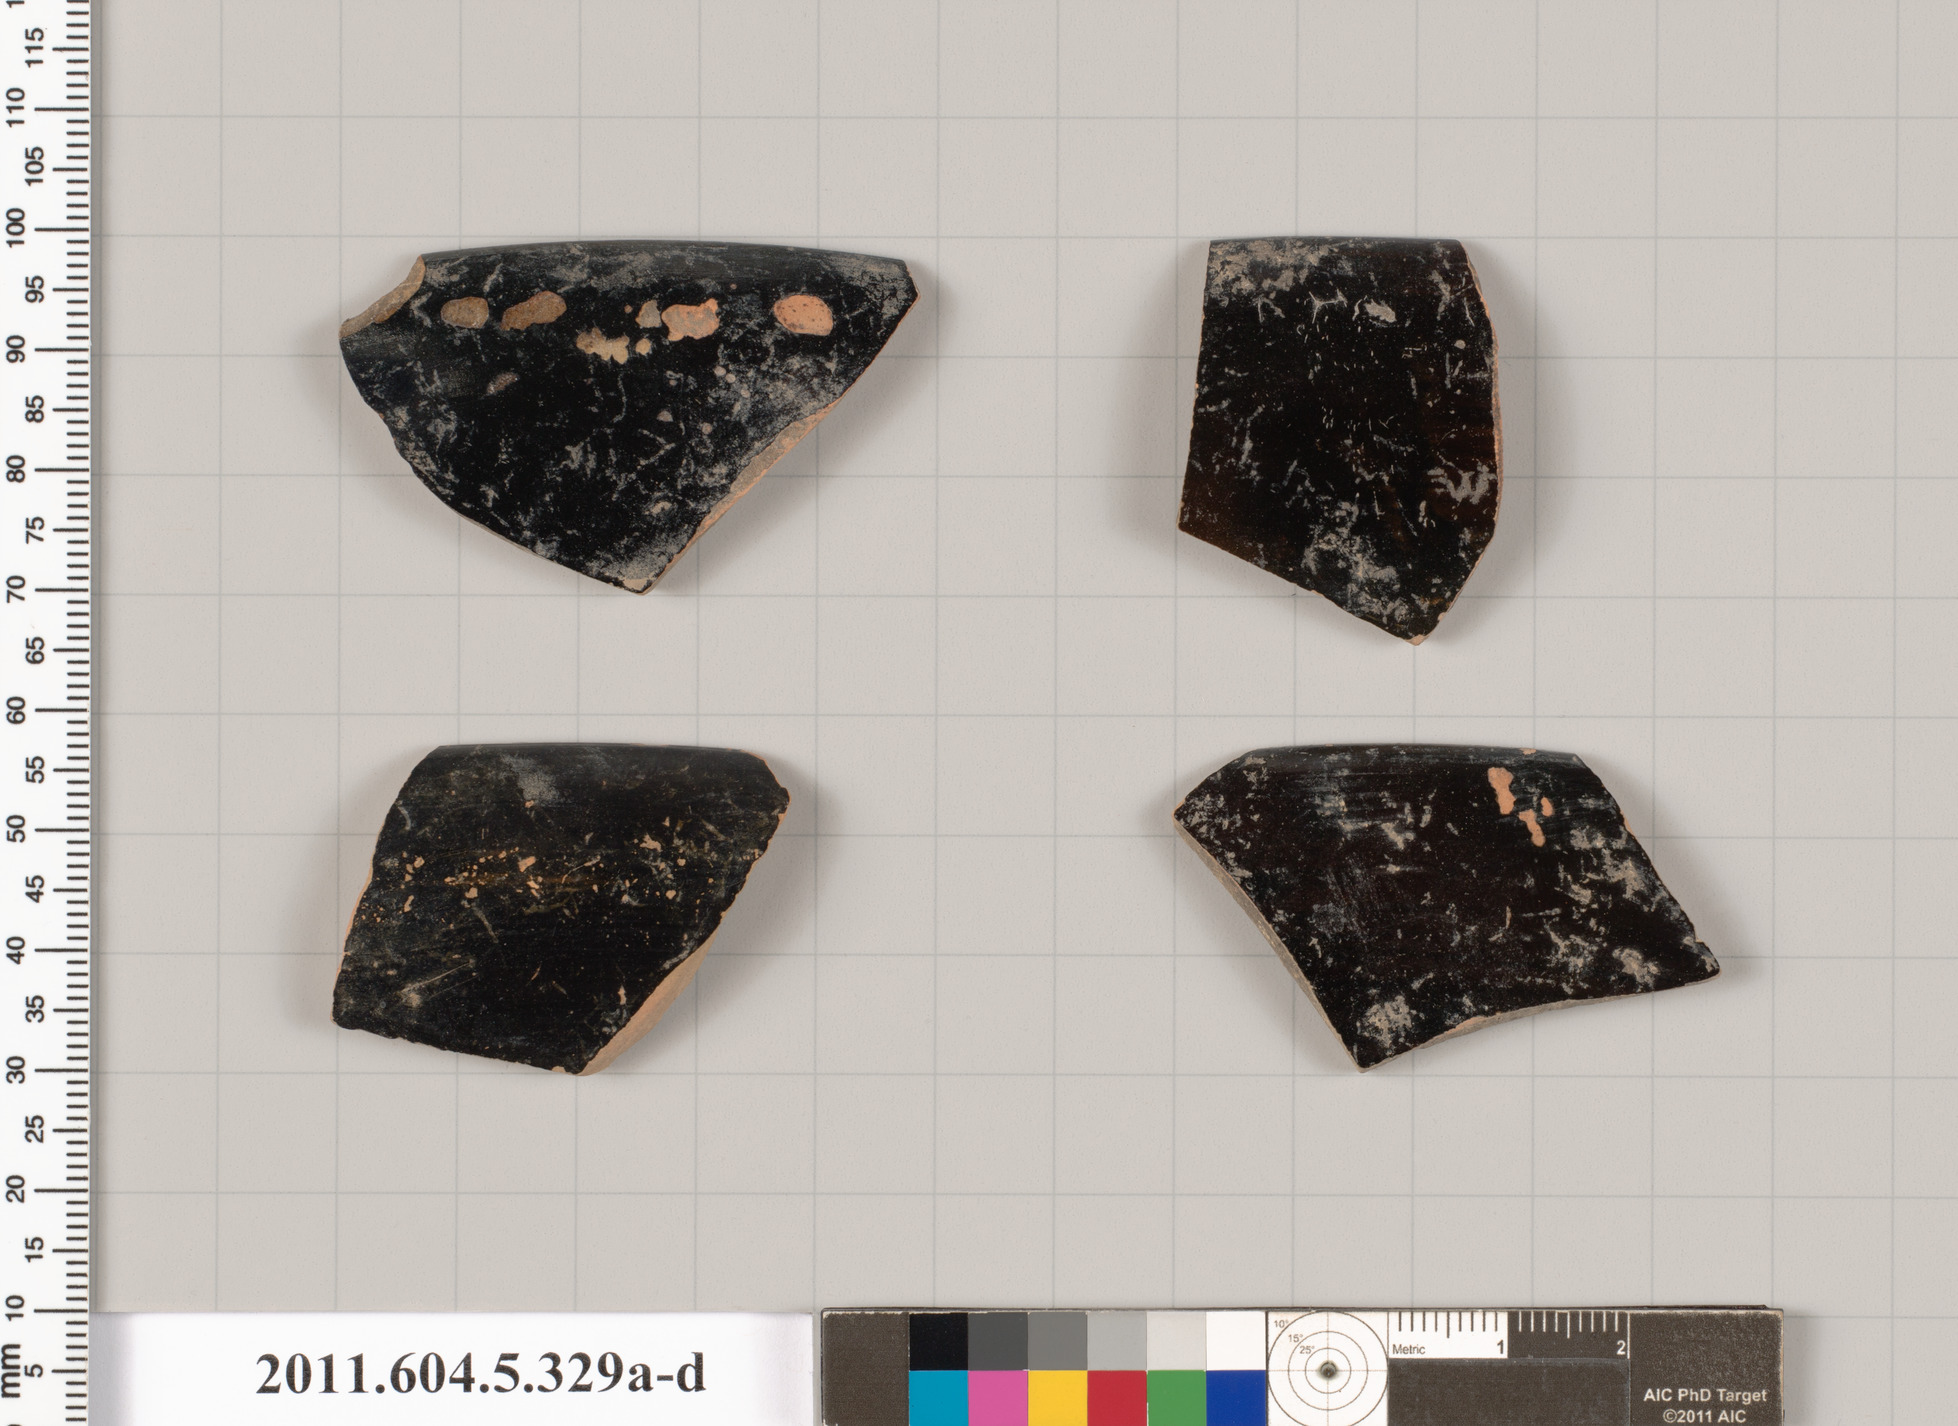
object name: kylix fragment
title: Terracotta rim fragments of kylikes (drinking cups)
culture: greek, attic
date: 600-401 BCE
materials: terracotta